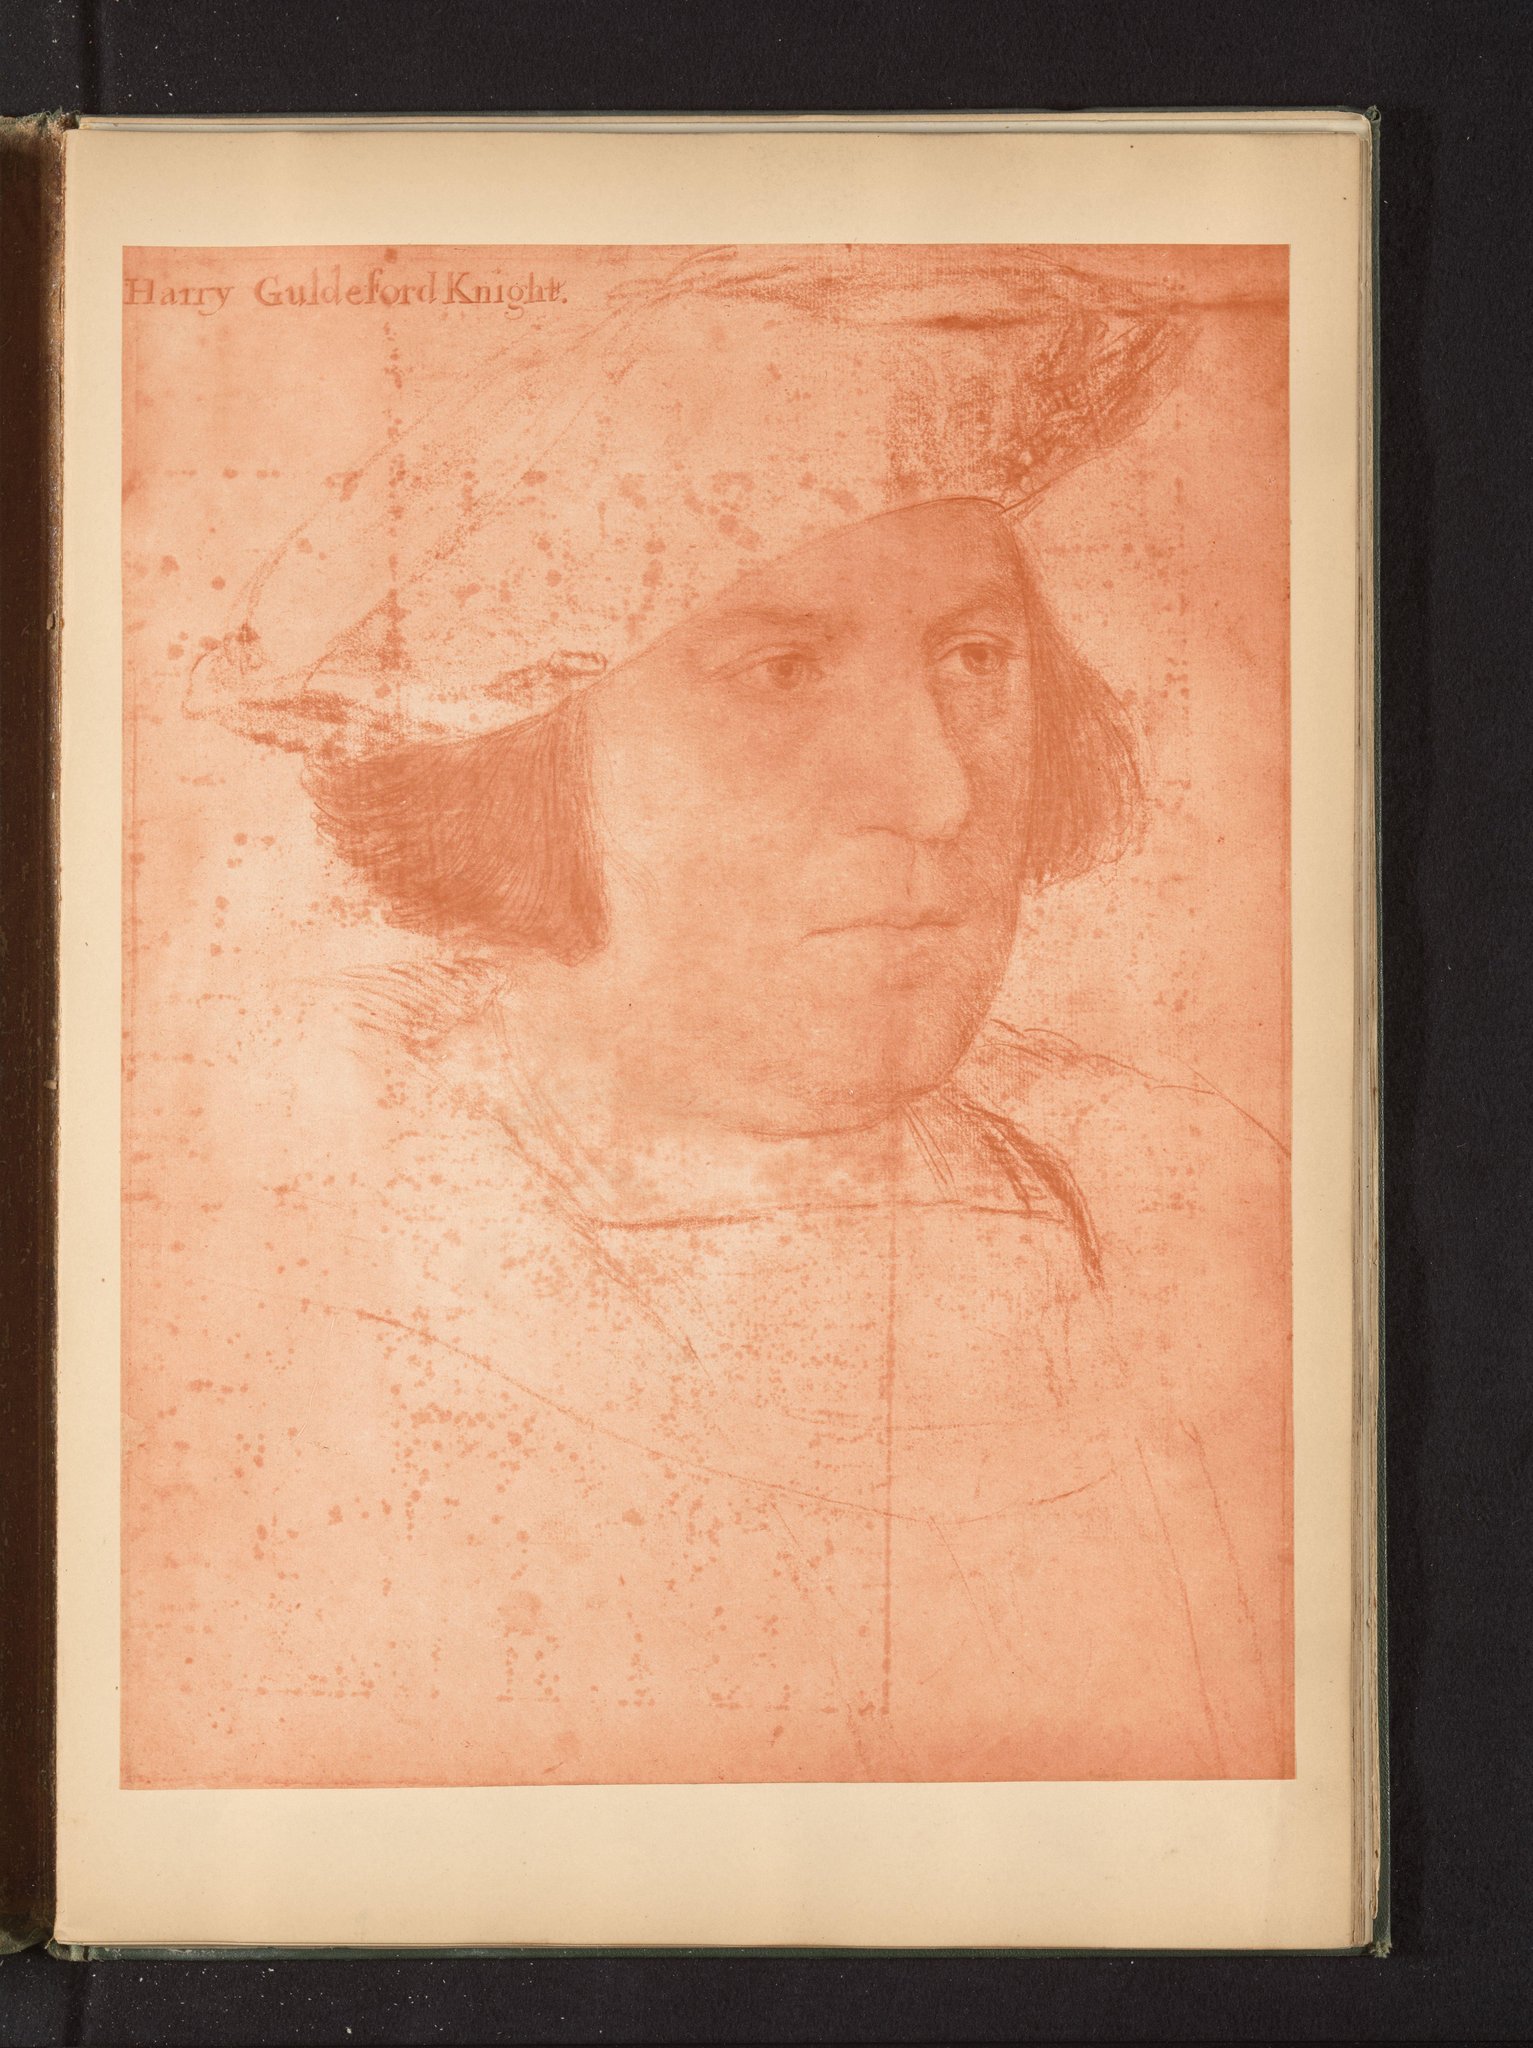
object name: page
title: Fotoreproductie van een portret van Henry Guildford door Hans Holbein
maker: Anonymous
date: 1872-1877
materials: paper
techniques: carbon print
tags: drawing, sketch, historical persons, royal household; courtiers, retinue, train